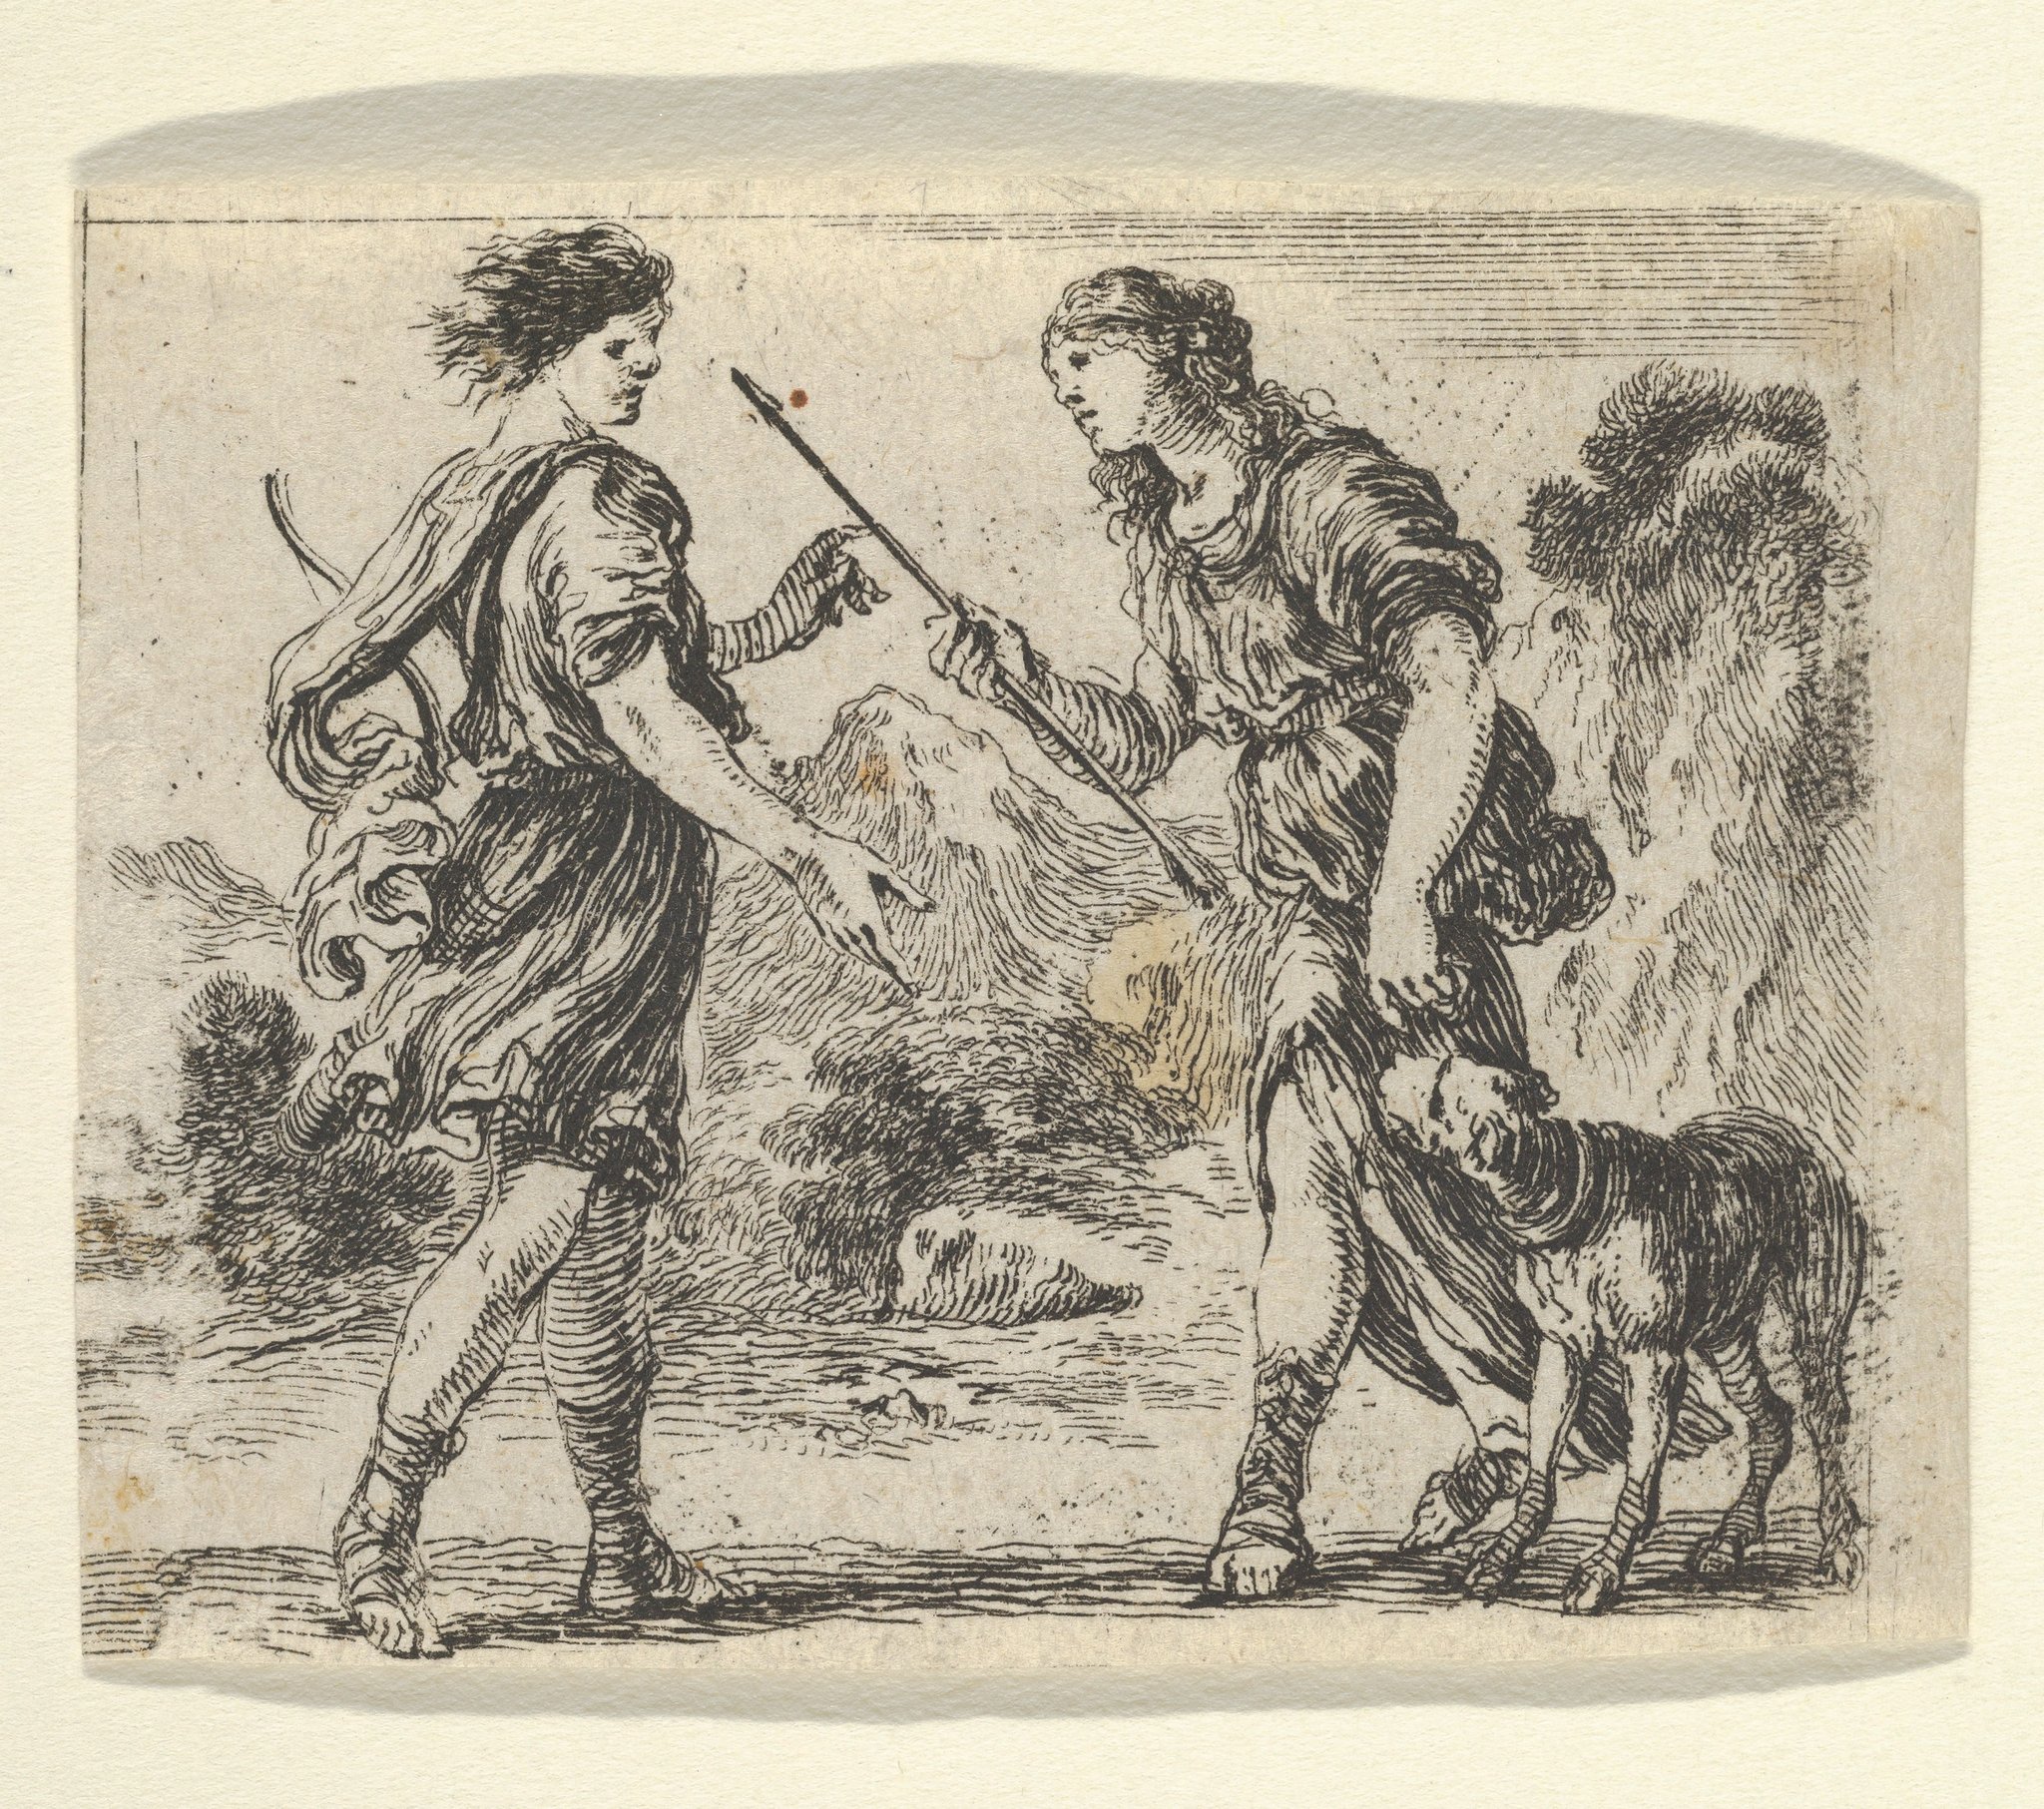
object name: print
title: Cephalus and Procris, from "Game of Mythology" (Jeu de la Mythologie)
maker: stefano della bella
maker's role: artist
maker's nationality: italian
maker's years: 1610-1664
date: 1644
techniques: etching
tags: men,dogs